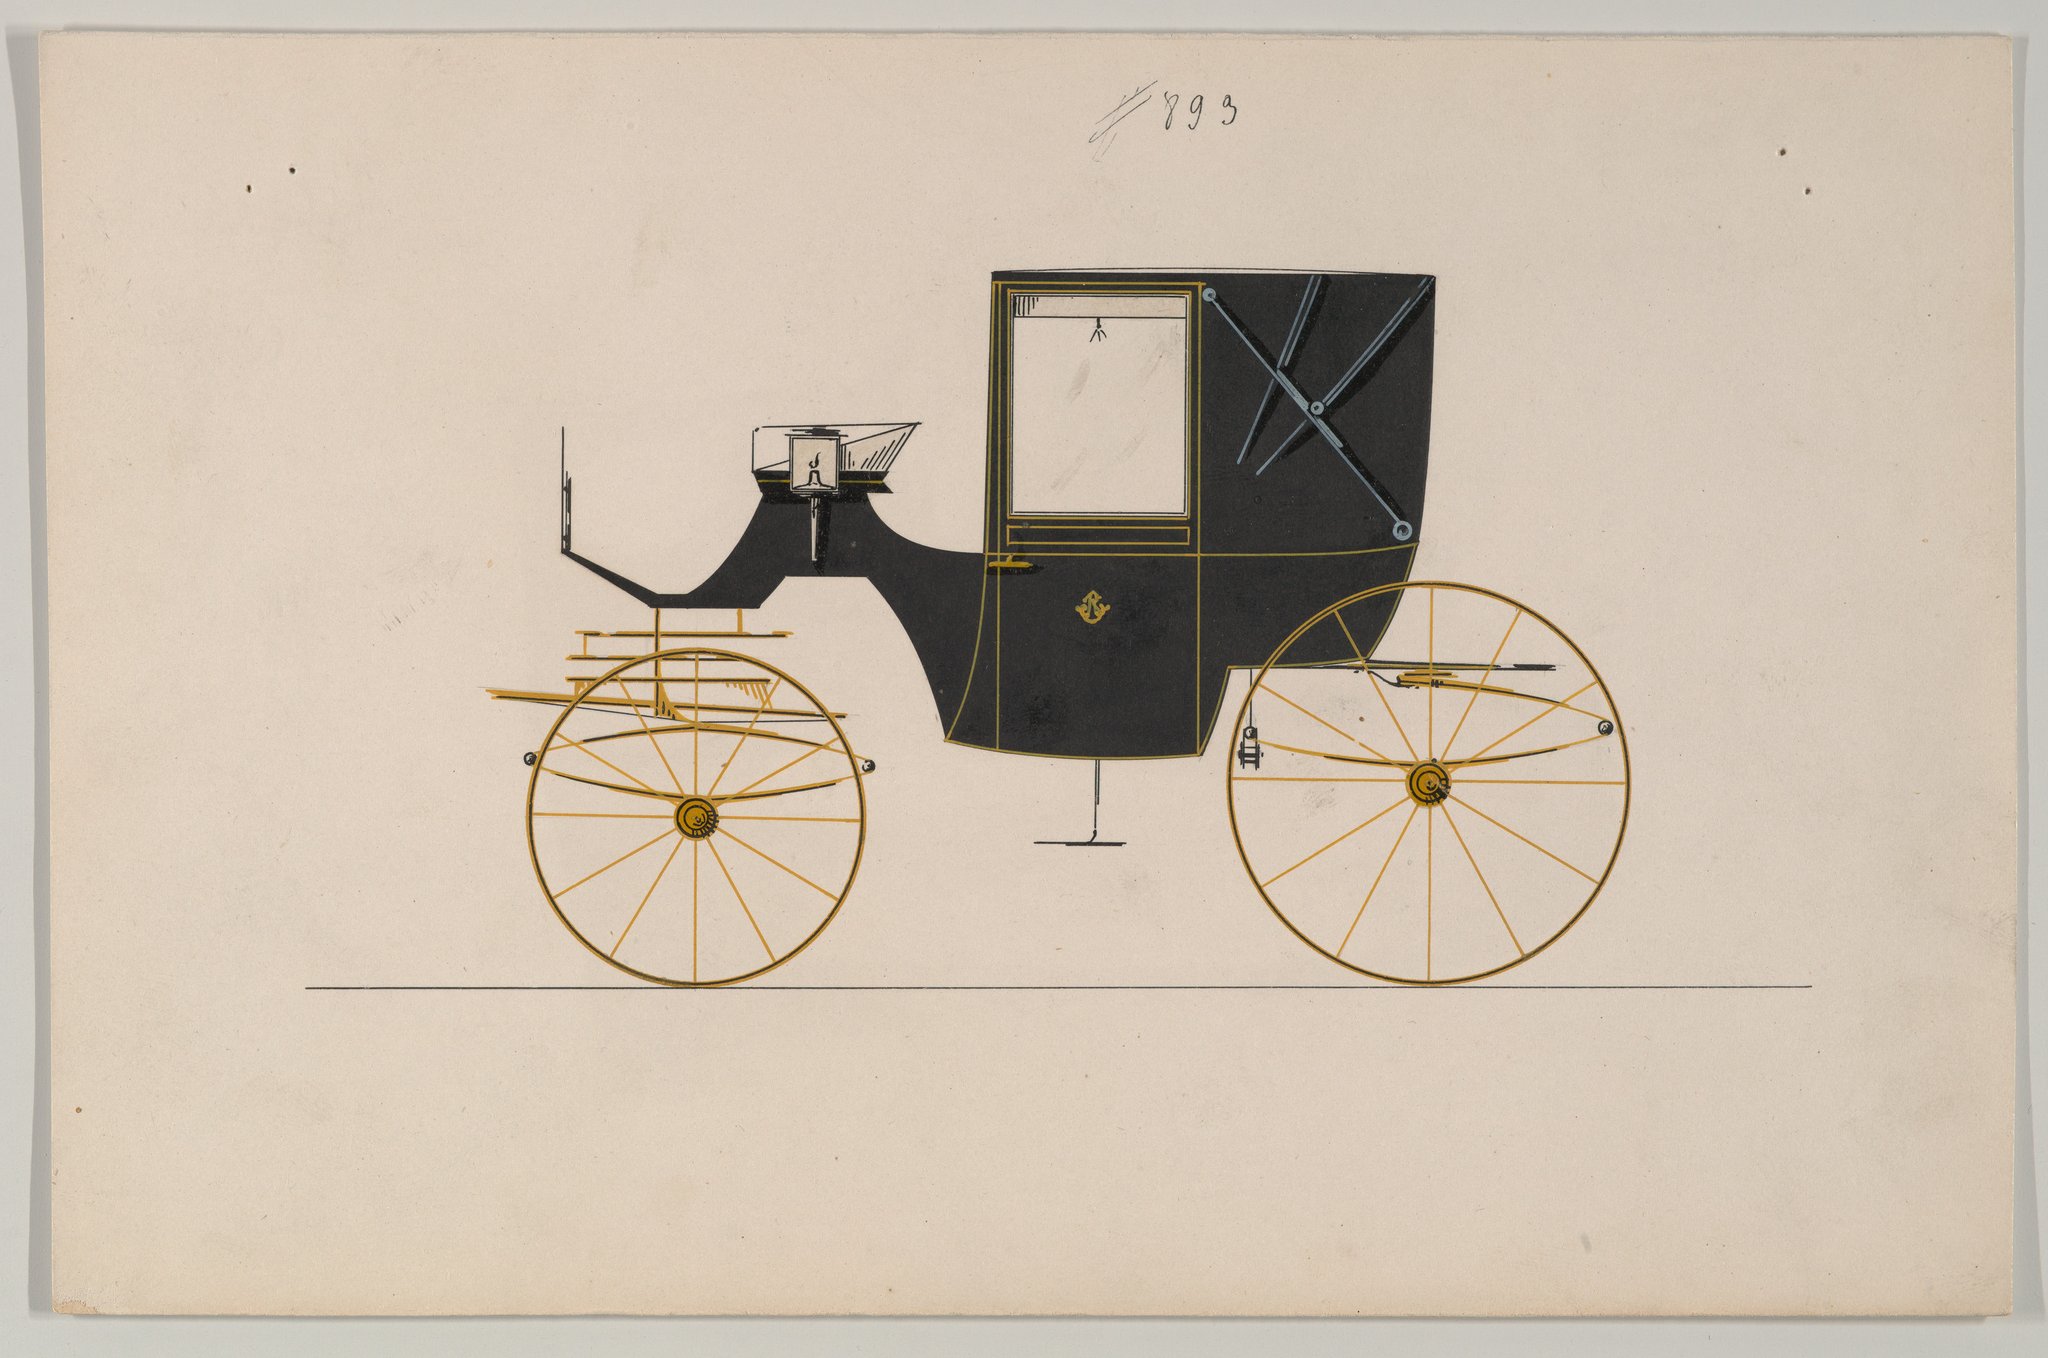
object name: drawing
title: Landaulet #893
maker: brewster & co.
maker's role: manufacturer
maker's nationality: american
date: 1850-1870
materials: gouache, gum arabic, ink, watercolor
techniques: pen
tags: carriages